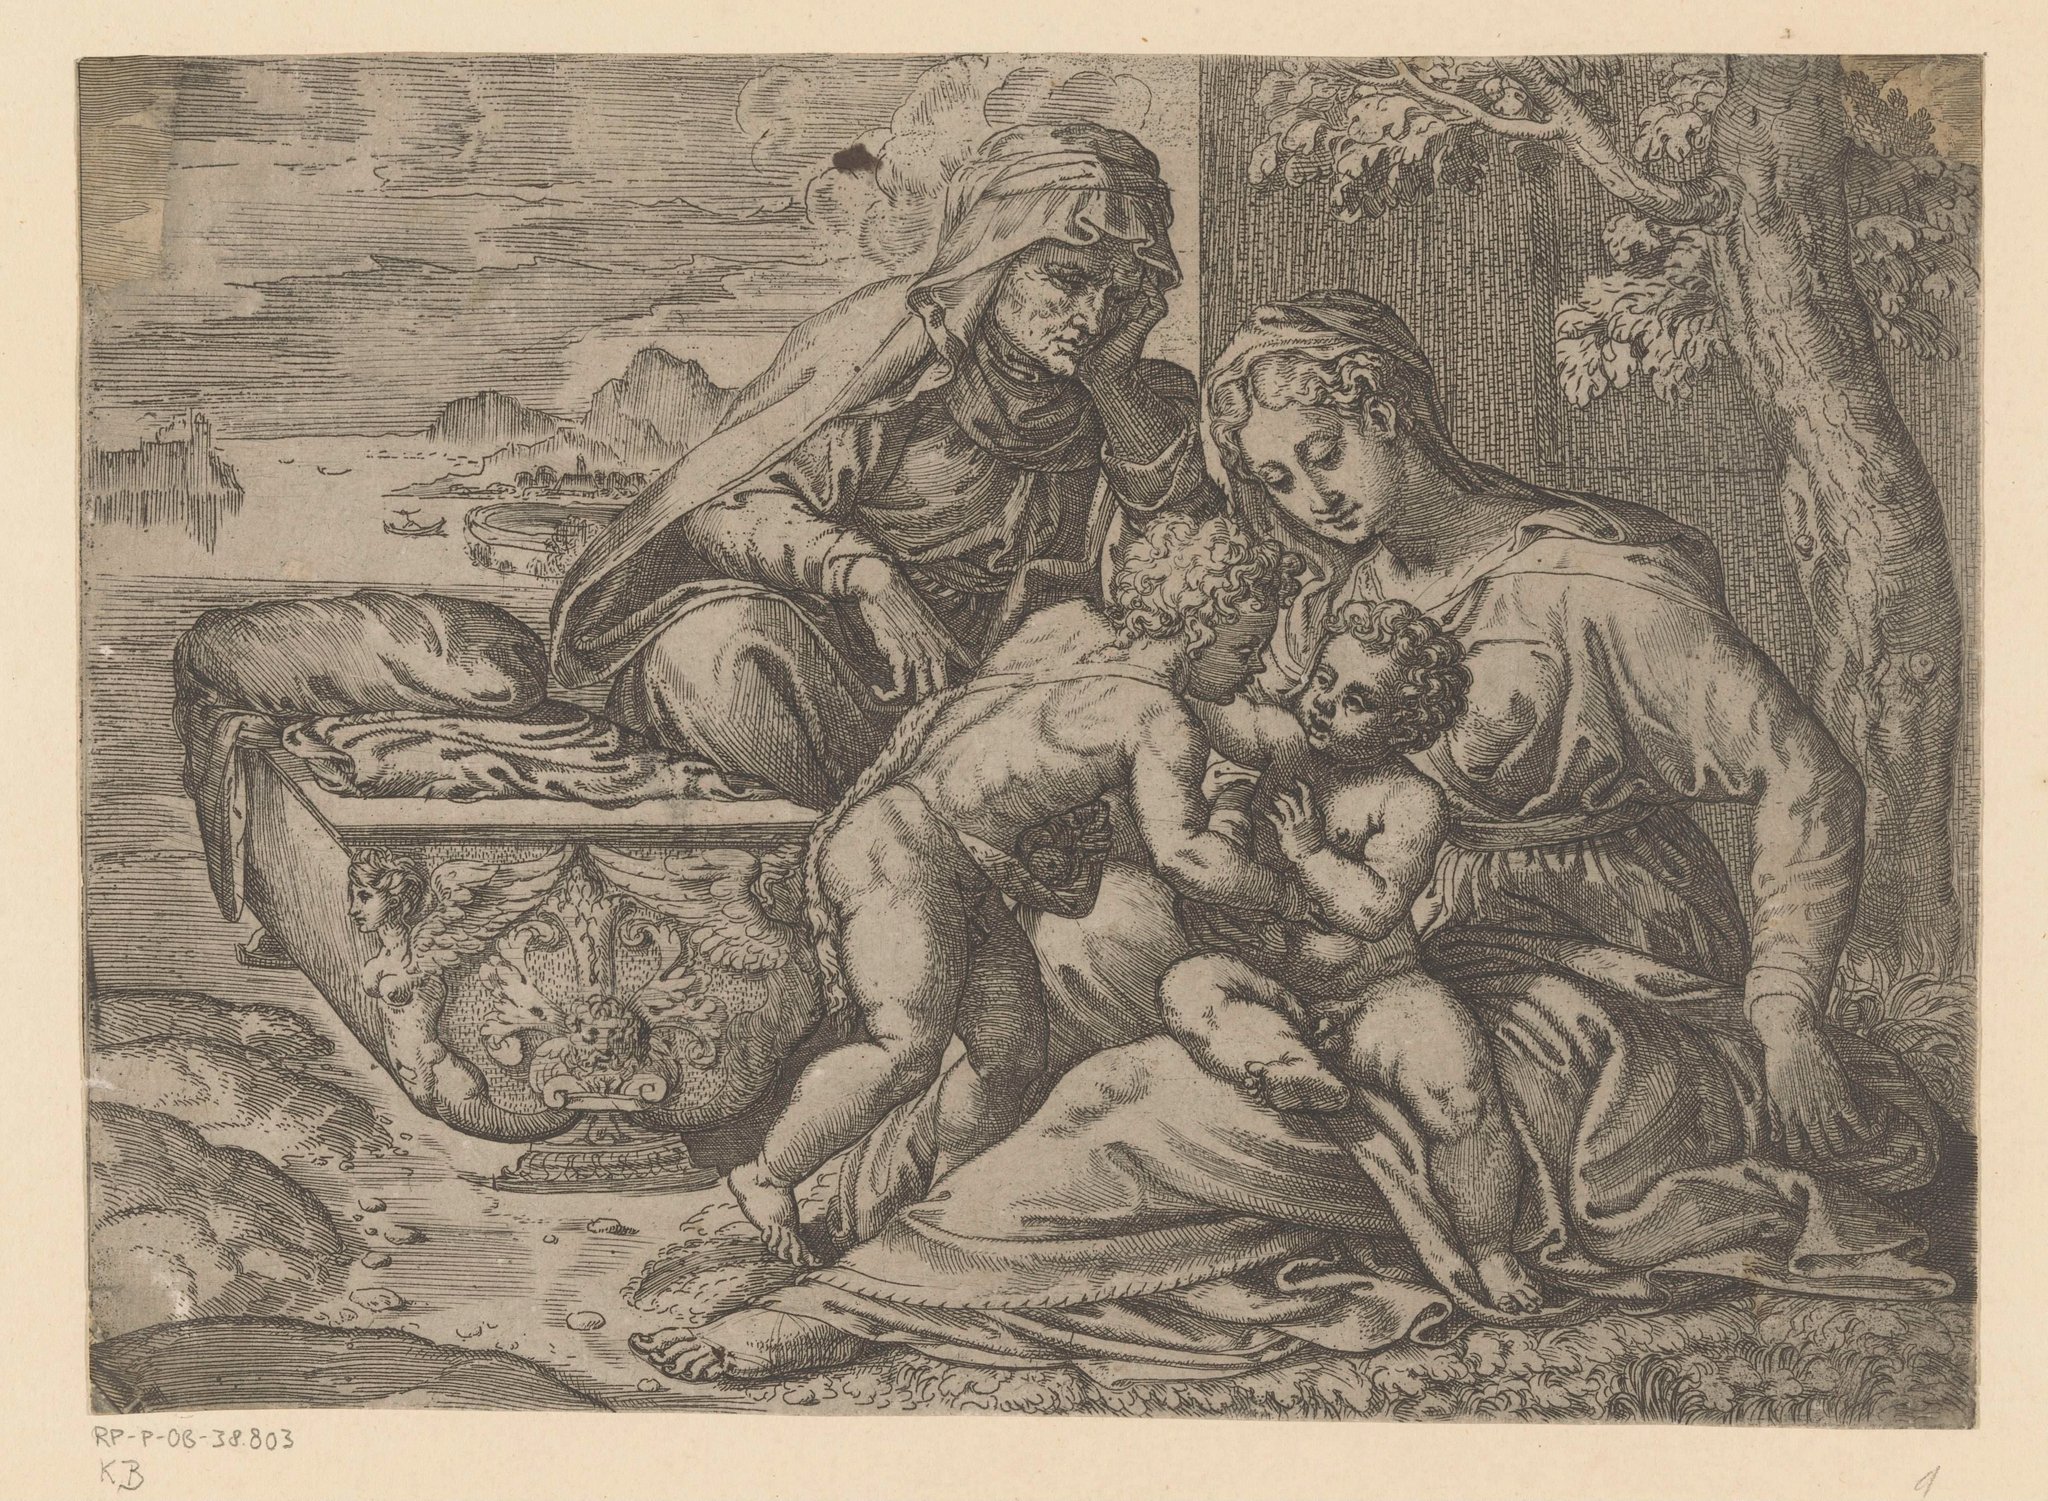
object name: print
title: Maria met het Christuskind, Johannes de Doper en Elisabet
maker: Anonymous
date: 1550-1649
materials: paper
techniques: engraving, etching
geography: italy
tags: river, mary, the christ-child and john the baptist, elisabeth present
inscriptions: collector's mark: Lugt 240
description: Maria met het Christuskind en de jonge Johannes de Doper met zijn moeder Elisabet. Links een kribbe en op de achtergrond een rivierlandschap.